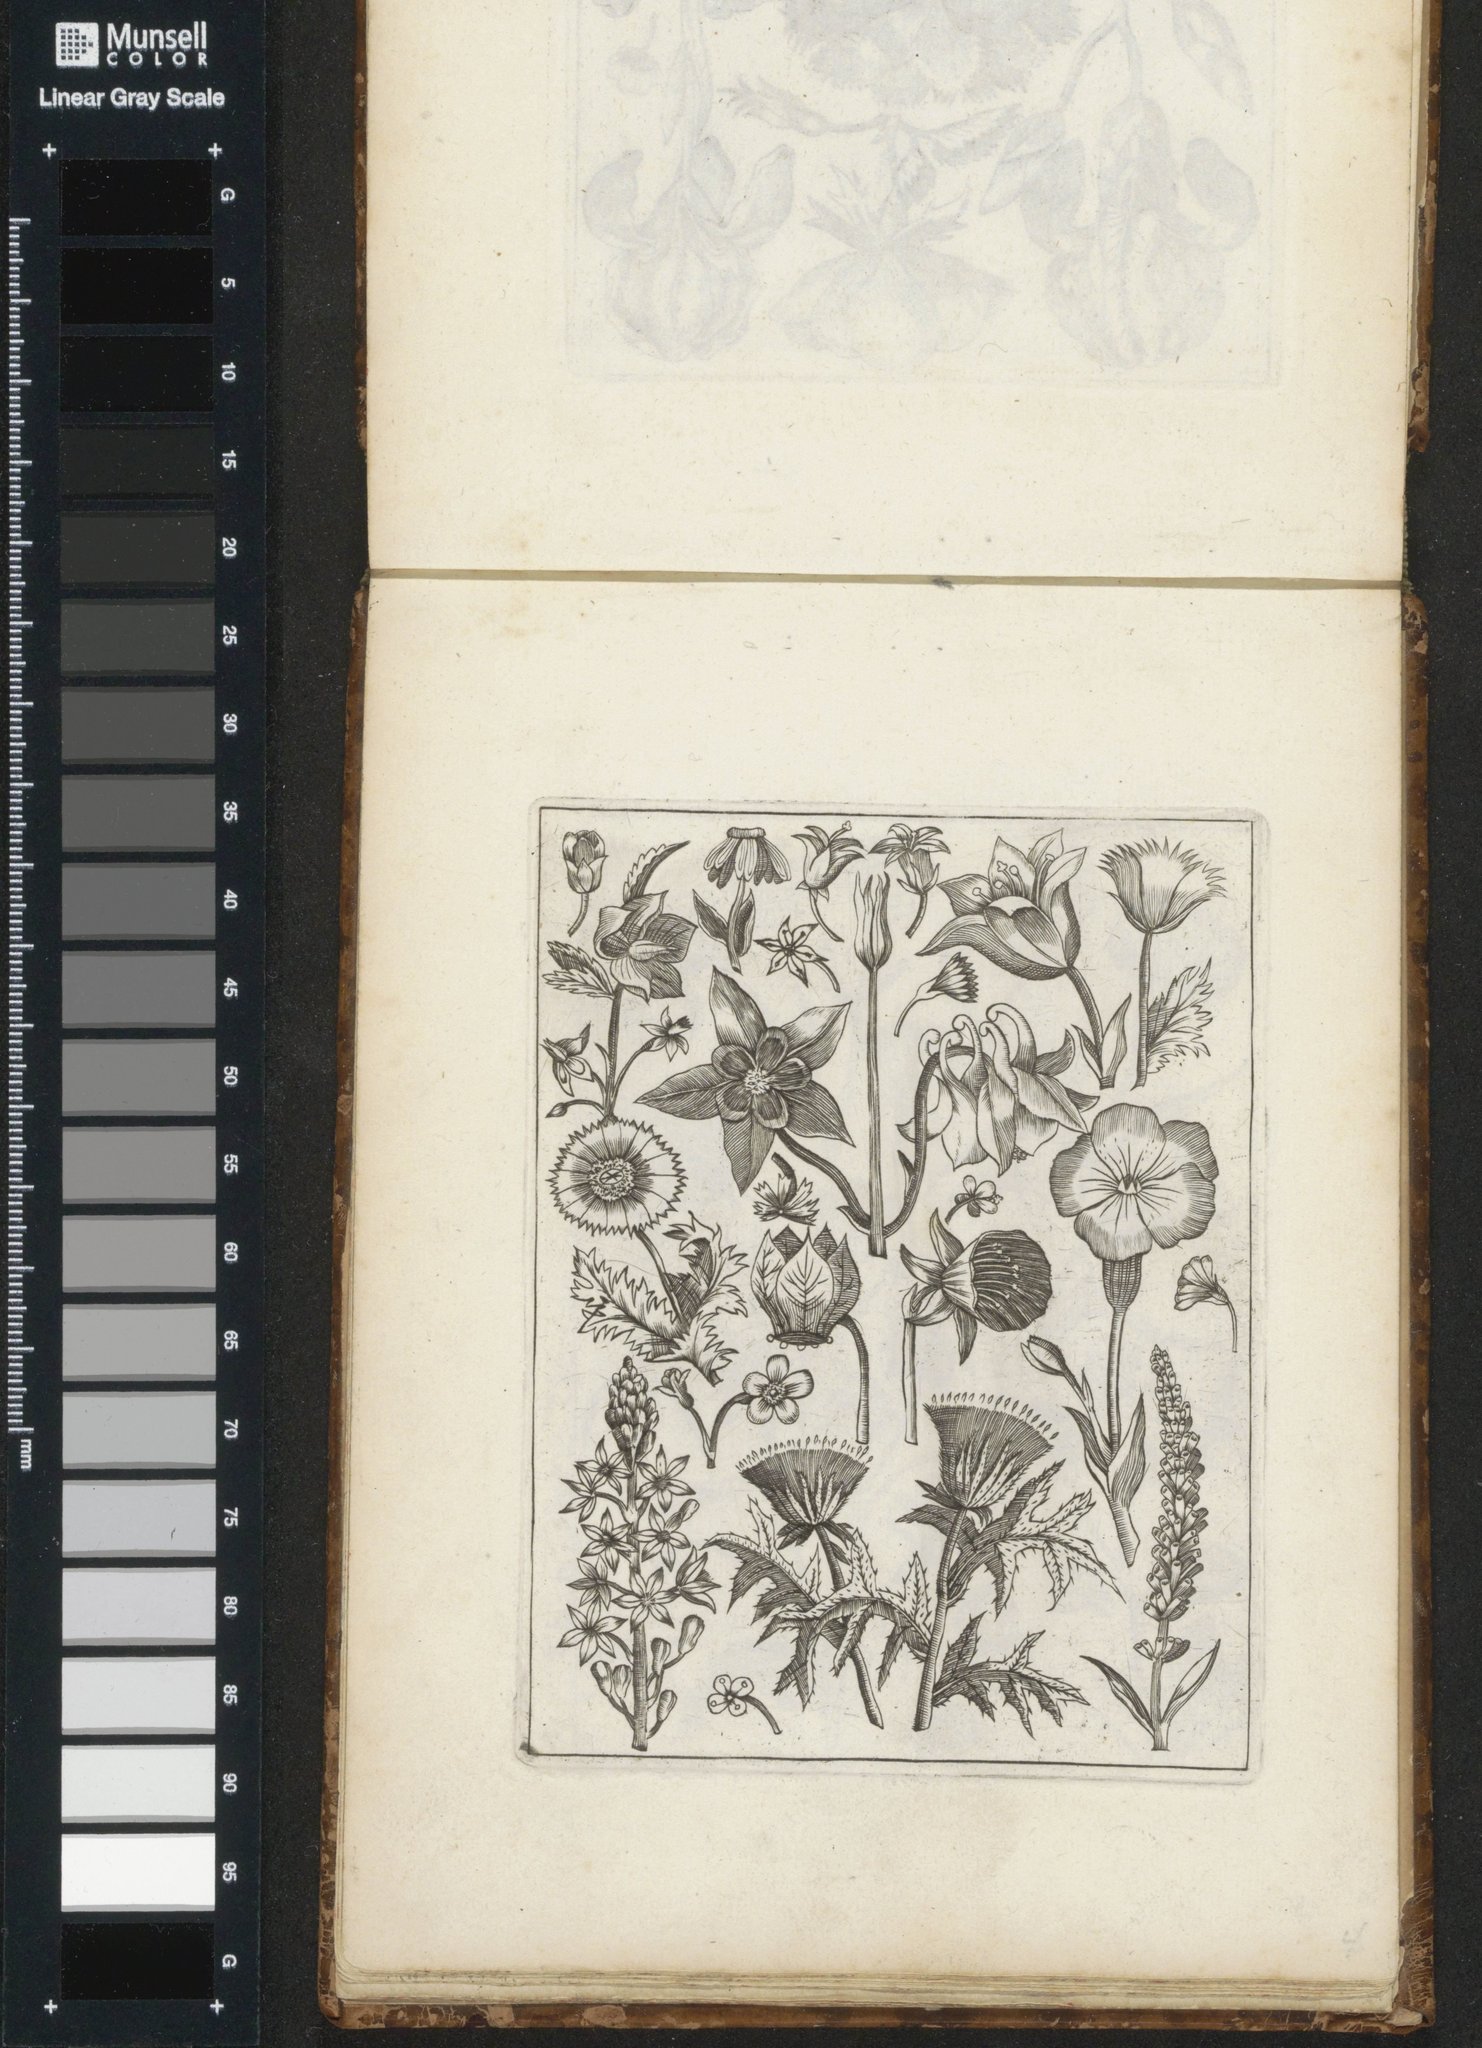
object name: album leaf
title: Bloemen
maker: Anonymous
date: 1635-1660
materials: paper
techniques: engraving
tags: flowers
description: Verschillende bloemen op een blad, onder andere campanula, tuinanjer en lelie. Deze prent maakt deel uit van een album.